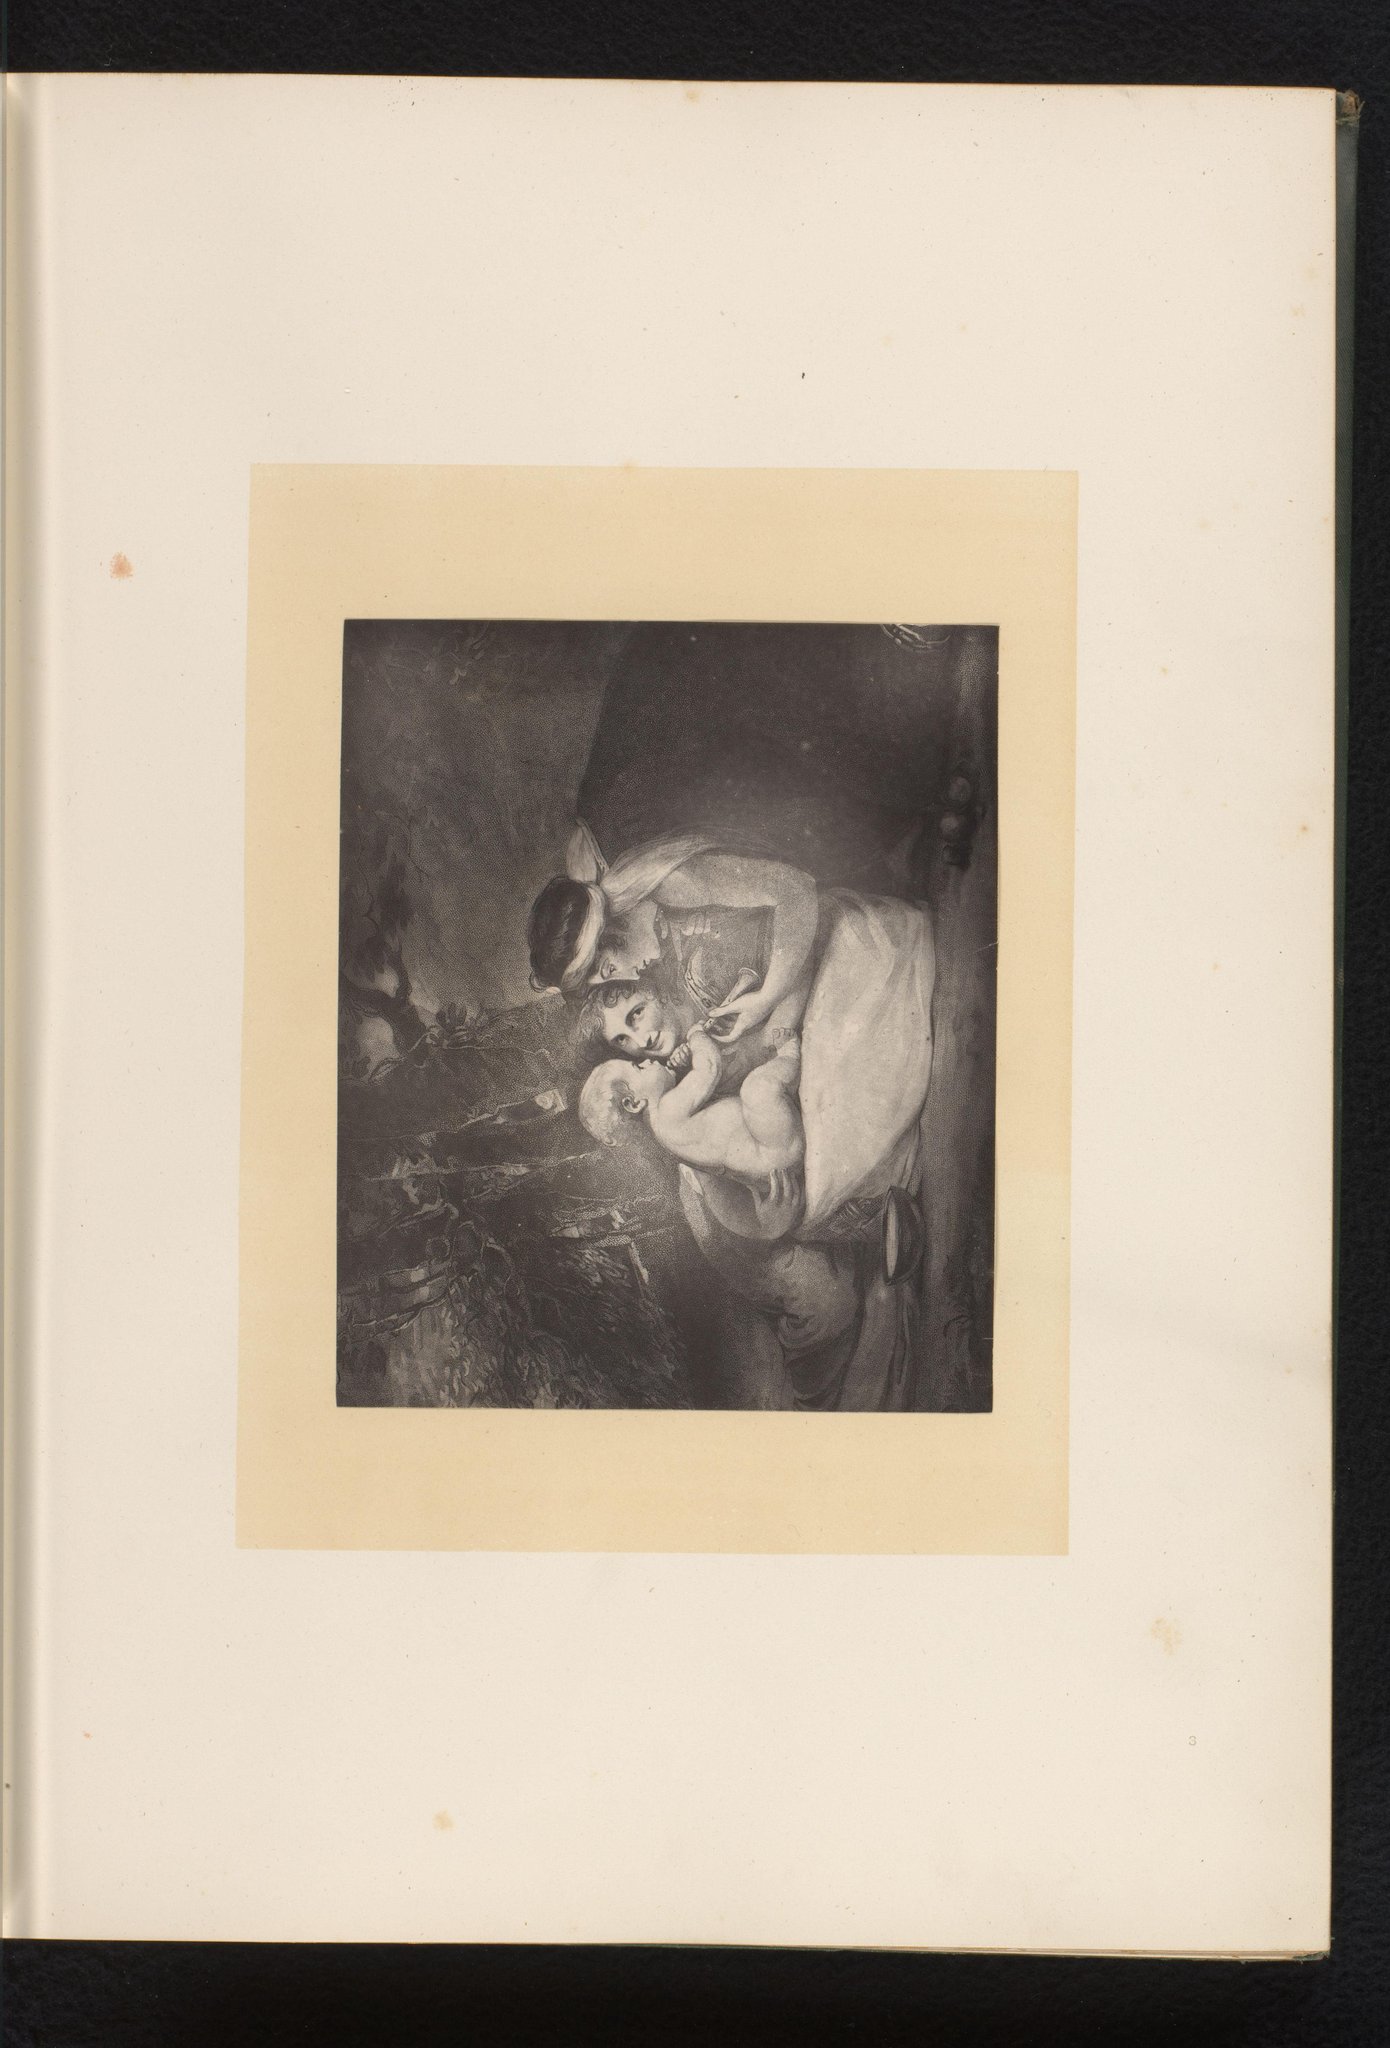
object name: photomechanical print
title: Shakespeare nursed by Tragedy and Comedy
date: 1874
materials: paper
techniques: woodburytype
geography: london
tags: william shakespeare, infancy (alleg.), inspiration of the poet; 'furore poetico' (ripa)